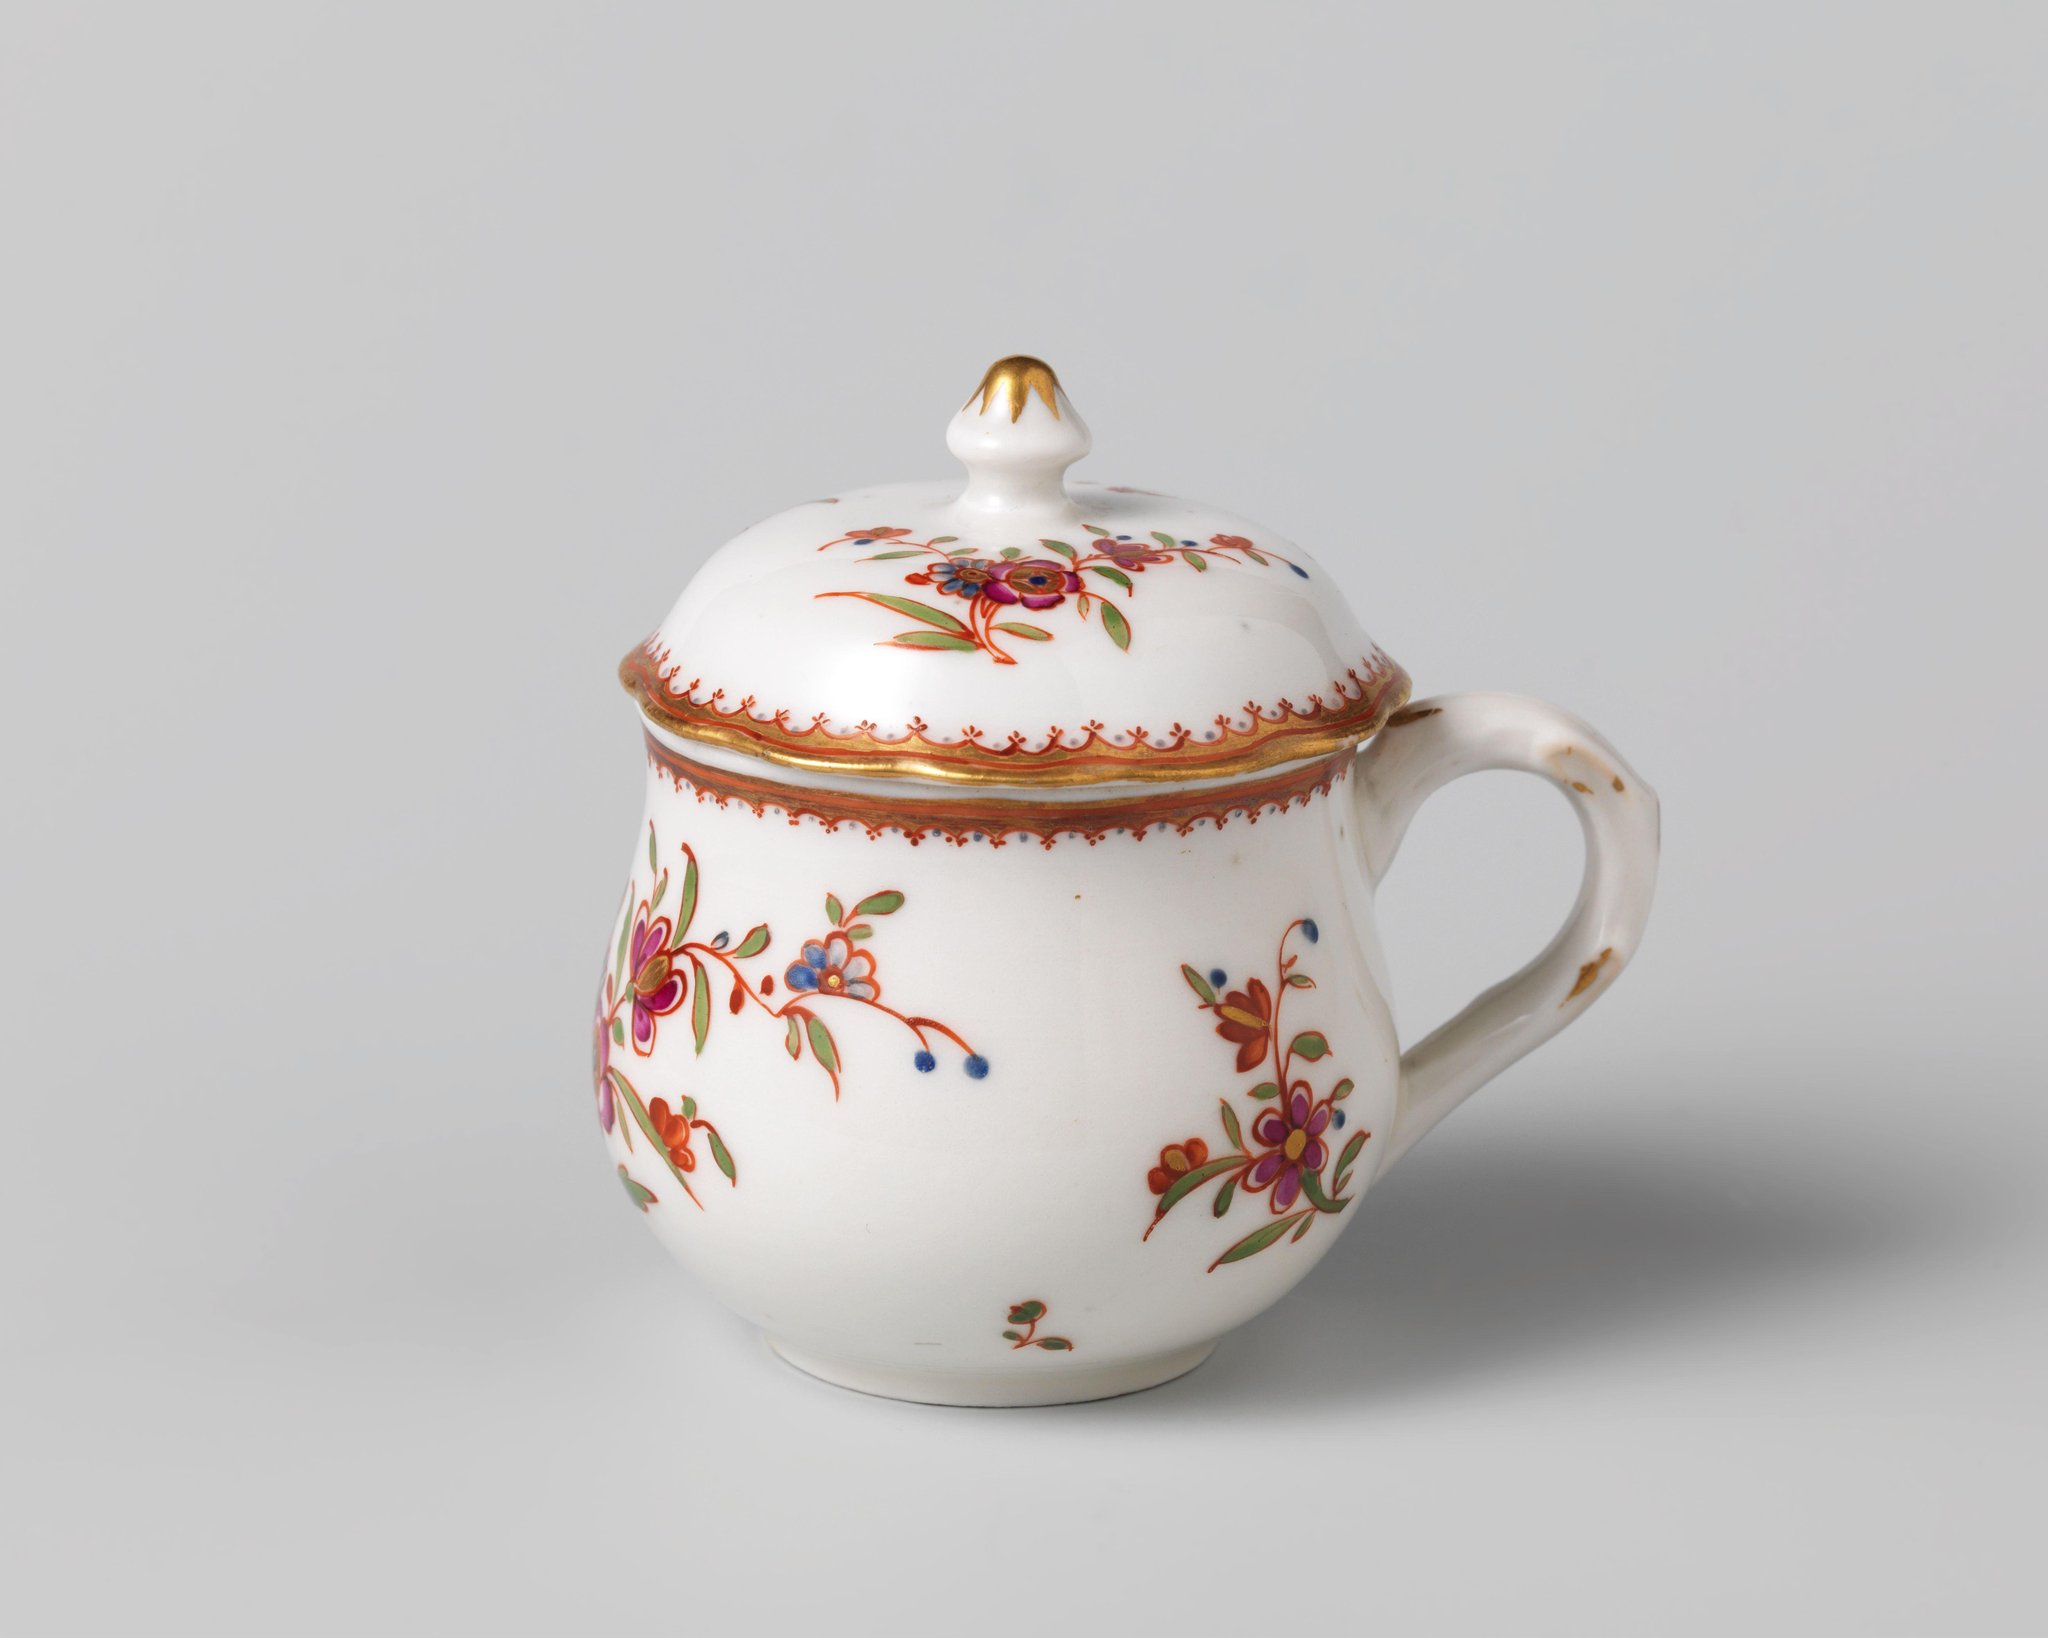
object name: crèmepot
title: Crèmepot, beschilderd met 'Indianische Blumen'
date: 1778-1782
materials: porcelain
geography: loosdrecht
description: Two cream pots. Porcelain. Loosdrecht, c. 1778 - 1782. Factory of Joannes de Mol.